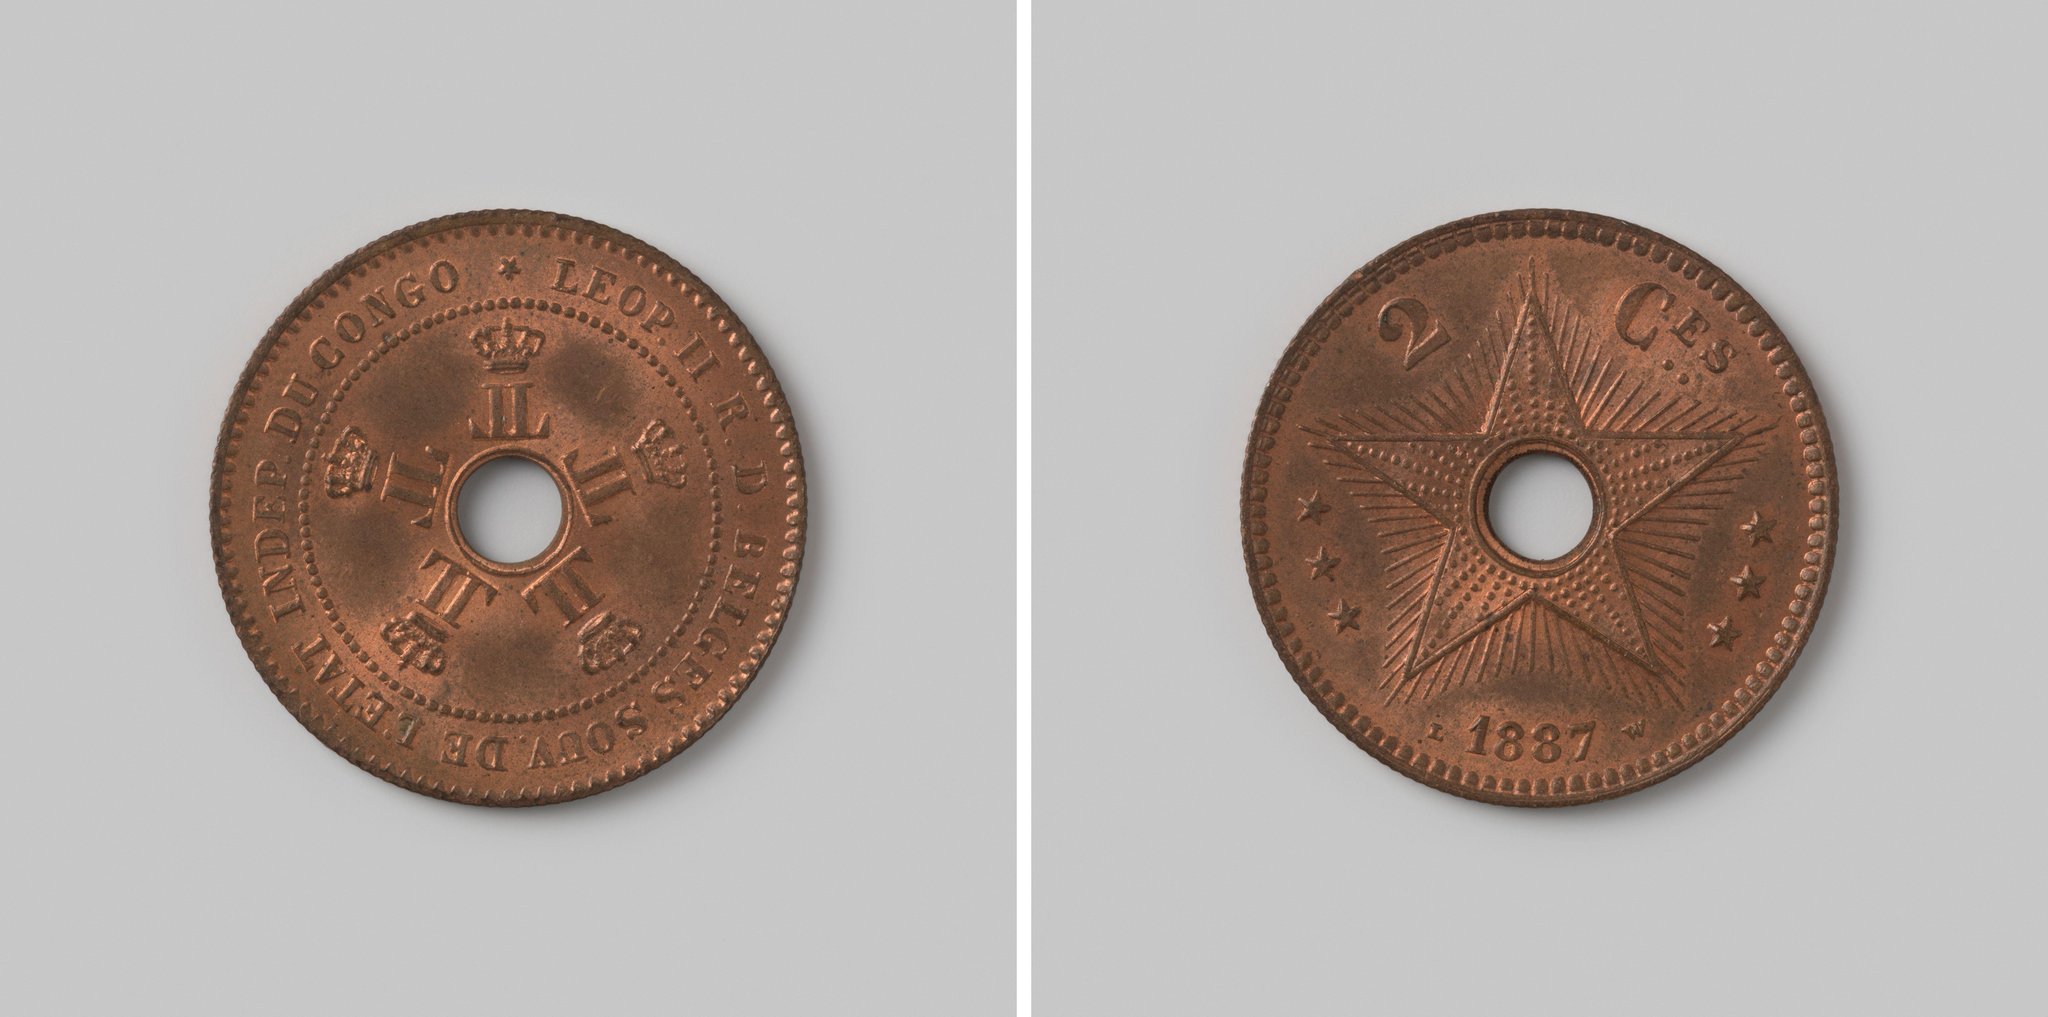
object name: twee centime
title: Congo Vrijstaat, koning Leopold II van België als soeverein, 2 centimes,1887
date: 1887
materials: copper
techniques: striking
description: Koperen munt met centrale doorboring. Voorzijde: rondom centrale doorboring vijf, in vijfpuntige stervorm geplaatste dubbele, ten opzichte van elkaar gespiegelde, letters L, waarboven een kroon [= koning Leopold II]. Keerzijde: rondom centrale doorboring vijfpuntige ster, waaruit stralen. In omschrift waarde-aanduiding: 2 Ces.. en jaartal. Kartelrand.